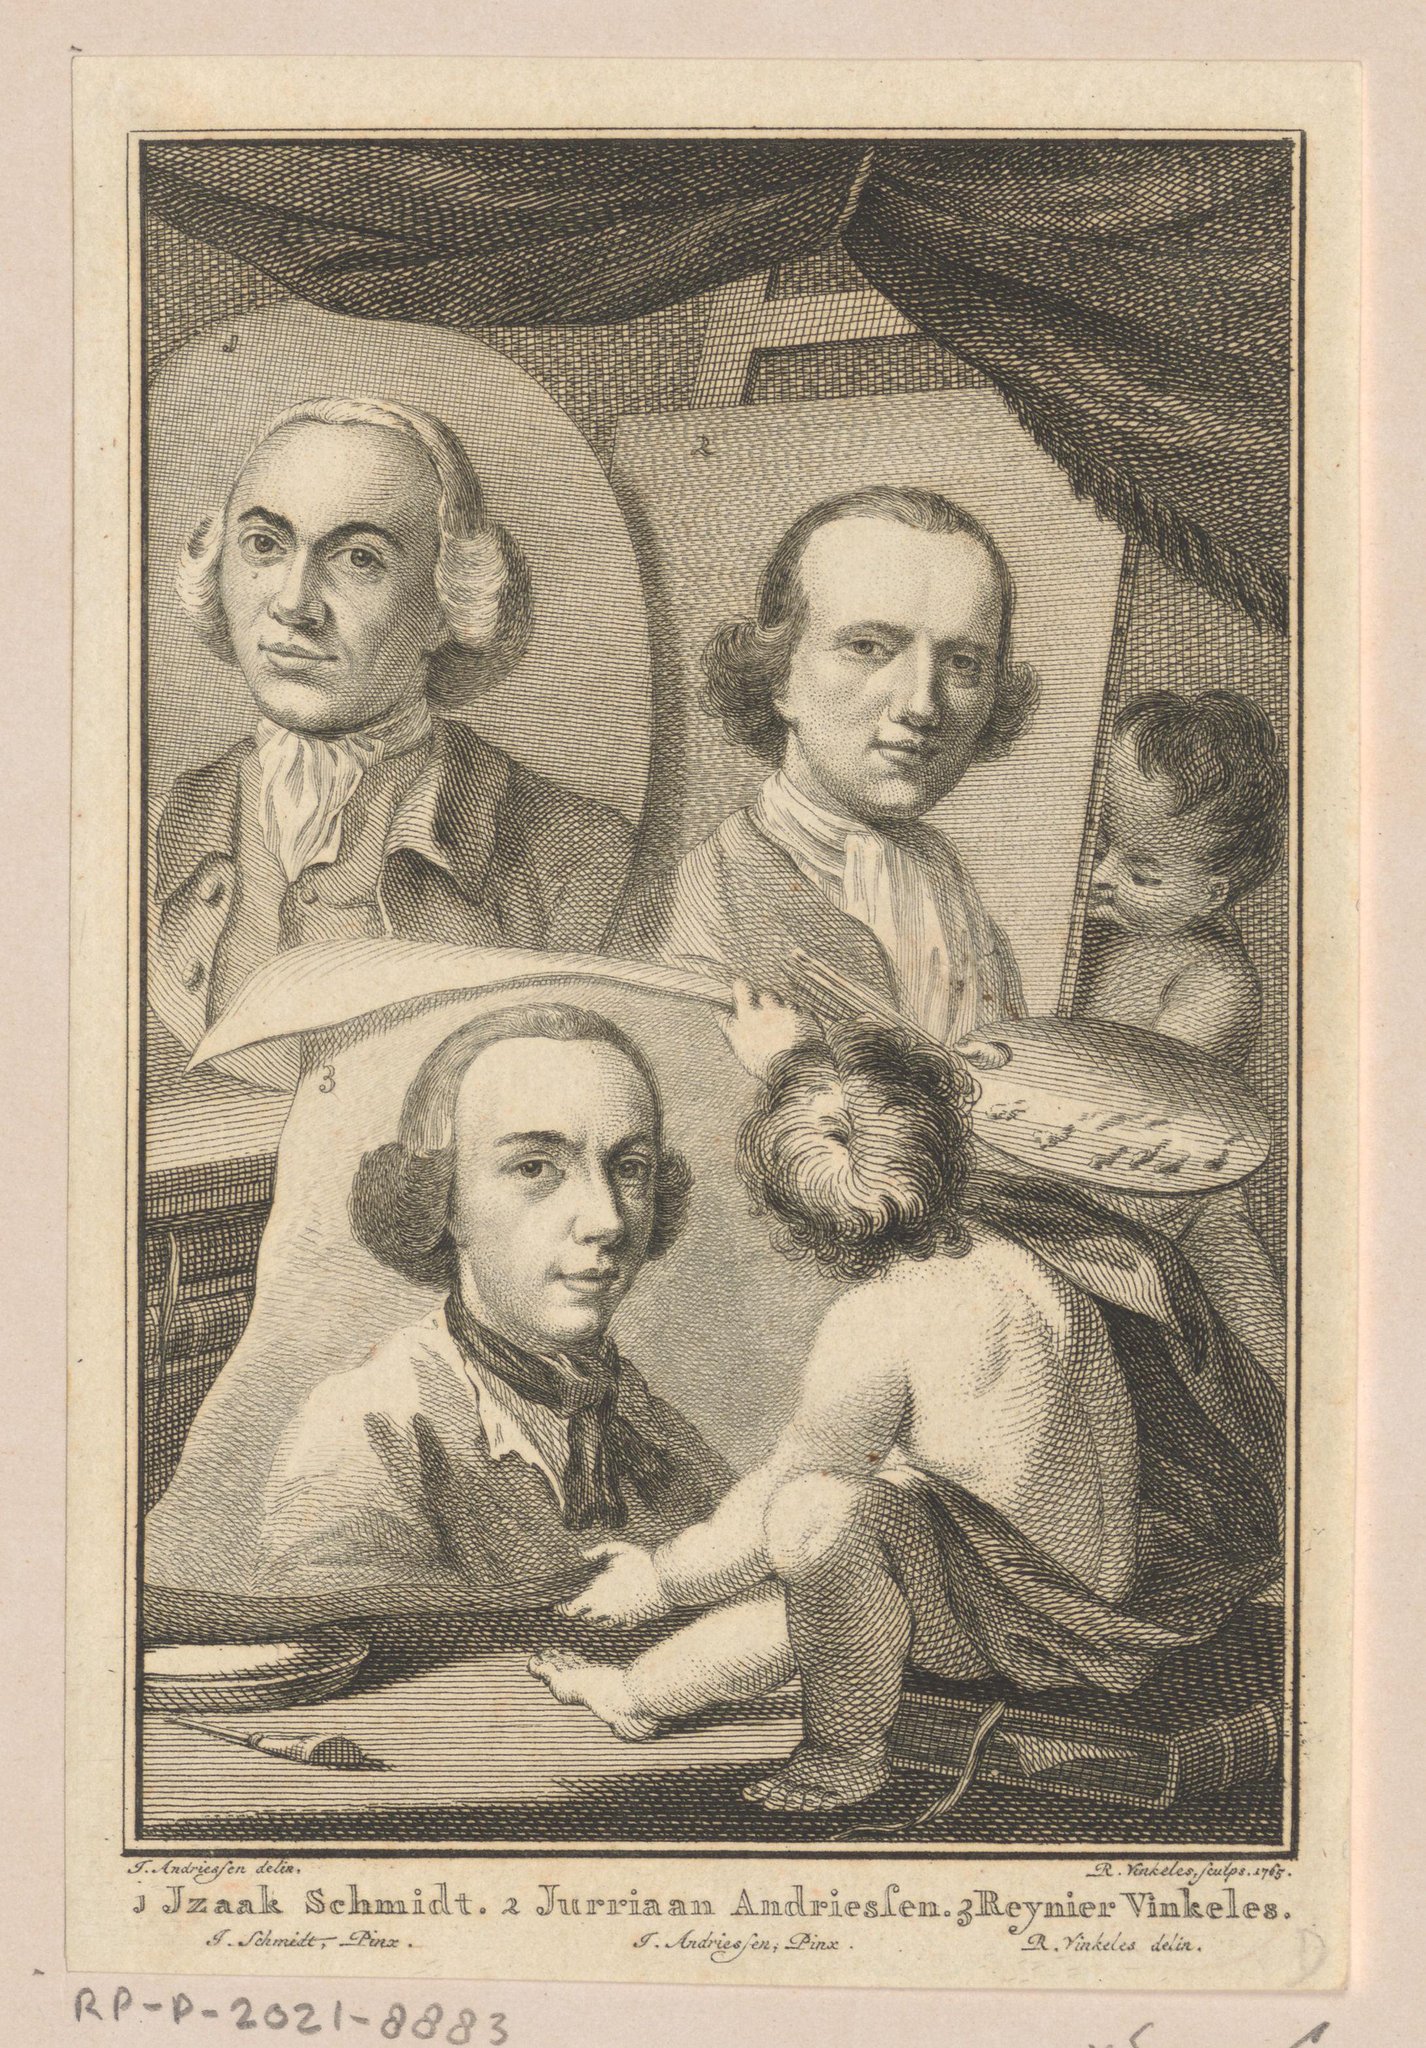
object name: print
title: Portret van Izaak Schmidt, Jurriaan Andriessen en Reinier Vinkeles I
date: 1765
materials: paper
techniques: etching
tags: painter, draughtsman, jurriaan andriessen, izaak schmidt, print maker, reinier vinkeles (i), historical persons, tools, implements of painter, portrait, self-portrait of artist, cupids: 'amores', 'amoretti', 'putti'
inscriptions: collector's mark: Lugt 240, inscription: ‘D’